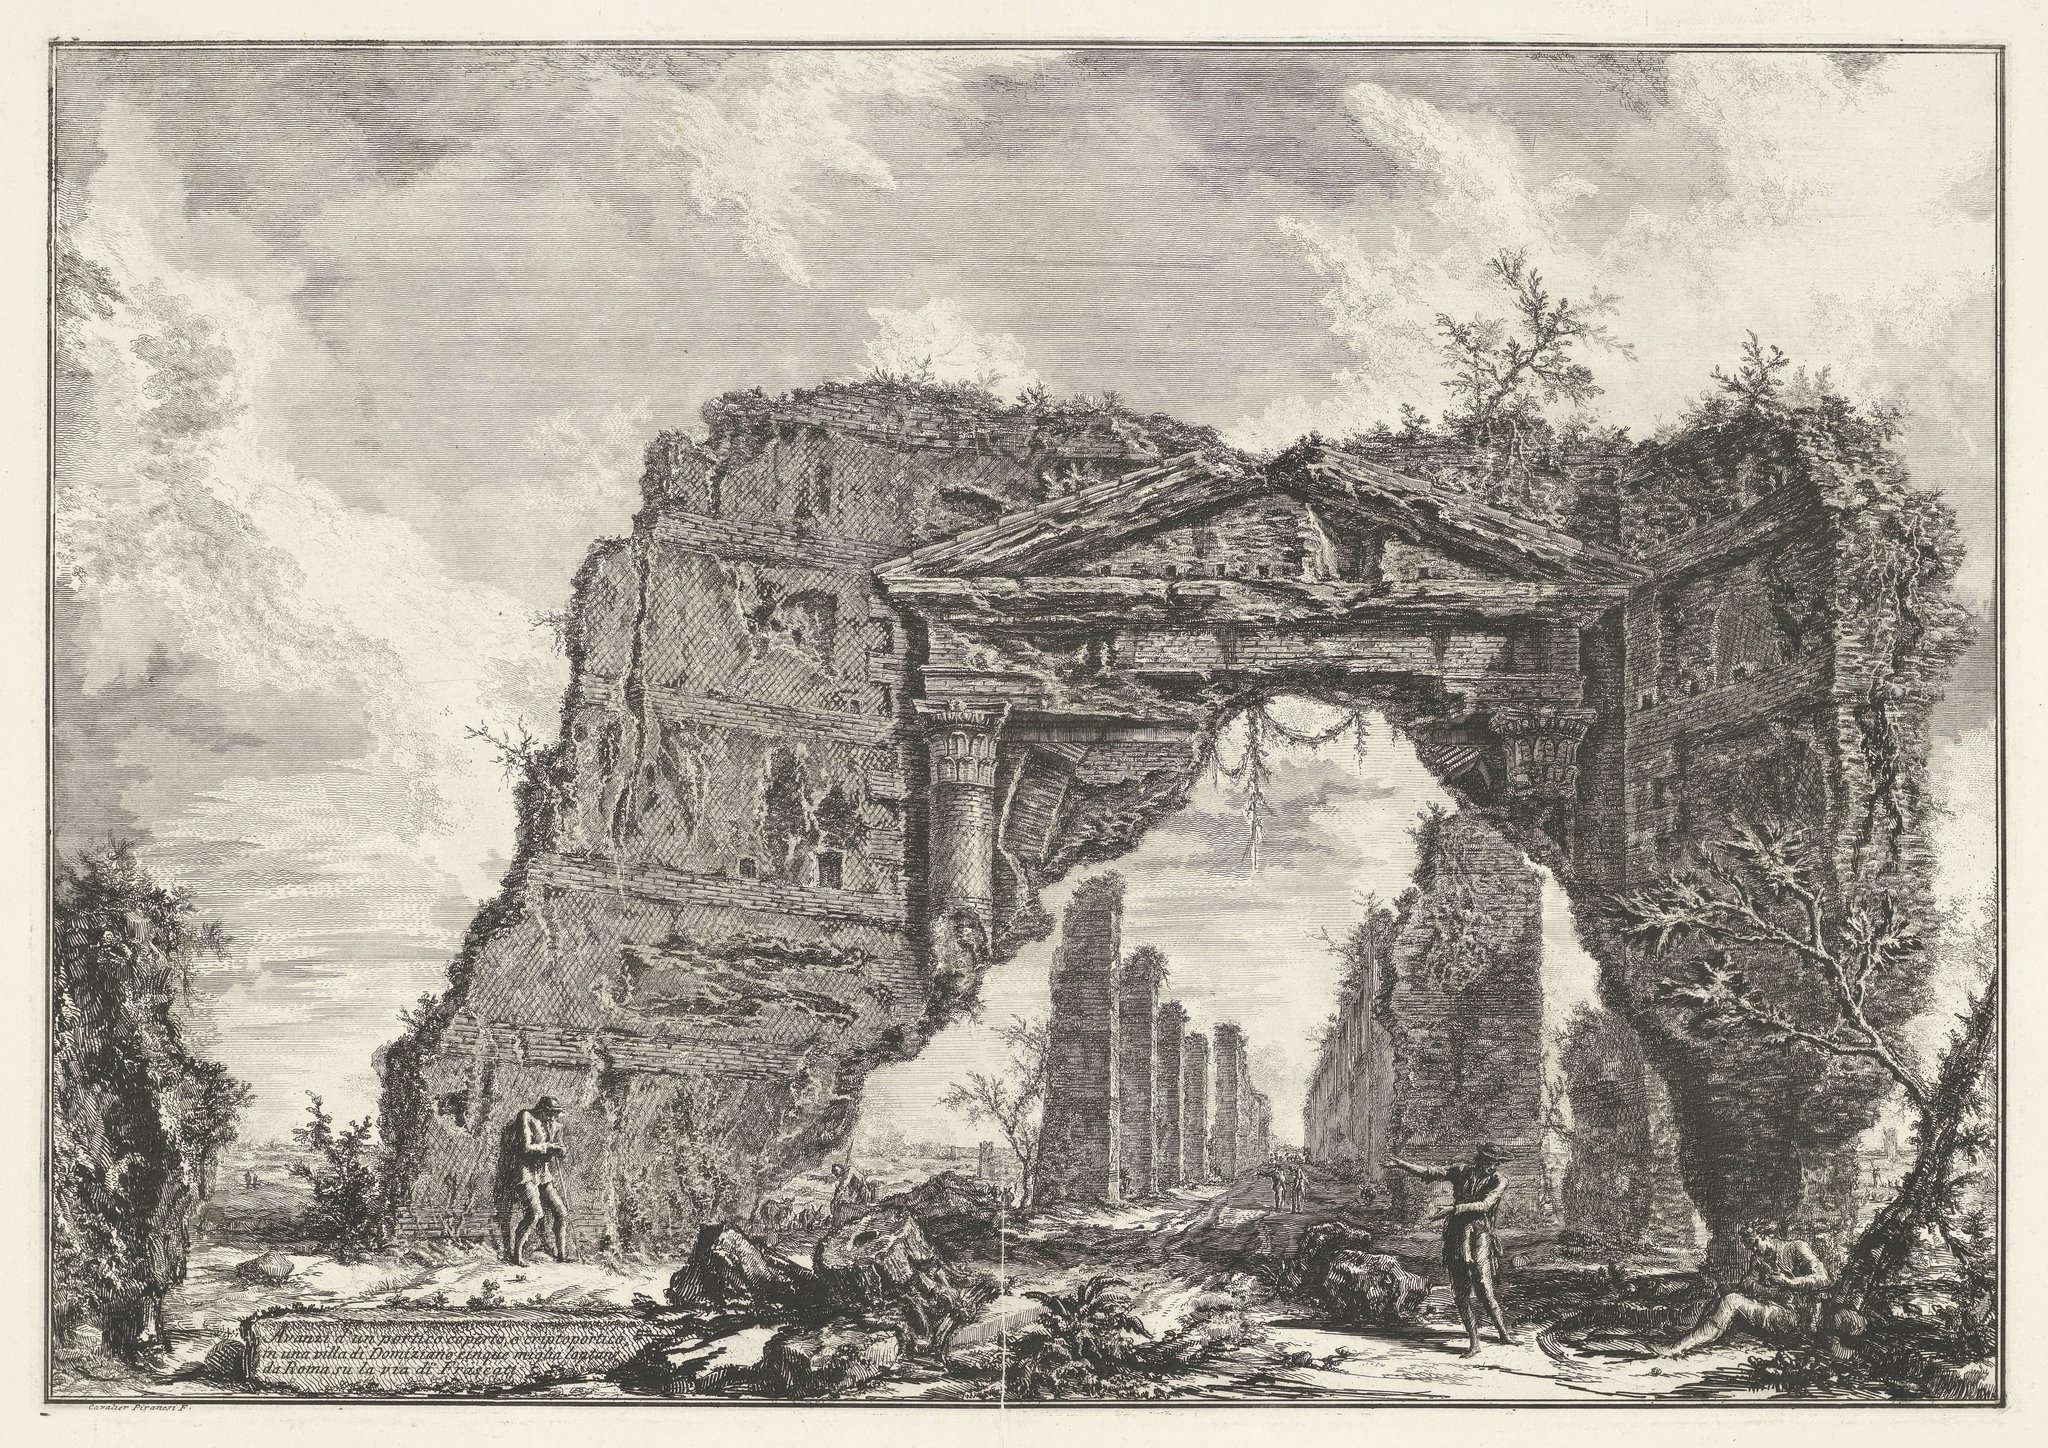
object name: print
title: Avanzi d'un portico coperto, o criptoportico in una villa di Domiziano cinque miglia lontan da Roma su la via di Franscati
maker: giovanni battista piranesi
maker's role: designer, draughtsman, print maker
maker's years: 1720-1778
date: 1748-1778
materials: paper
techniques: etching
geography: rome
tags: city-view, and landscape with man-made constructions, ruin of a building ~ architecture, landscape with ruins, gate, entrance, rome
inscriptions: collector's mark: Lugt 2228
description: Deze prent maakt deel uit van de serie 'Vedute di Roma'. Piranesi werkte aan deze 135 platen tellende serie tussen 1748 en zijn dood in 1778. Francesco Piranesi voegde later nog twee prenten toe aan de reeks van zijn vader.